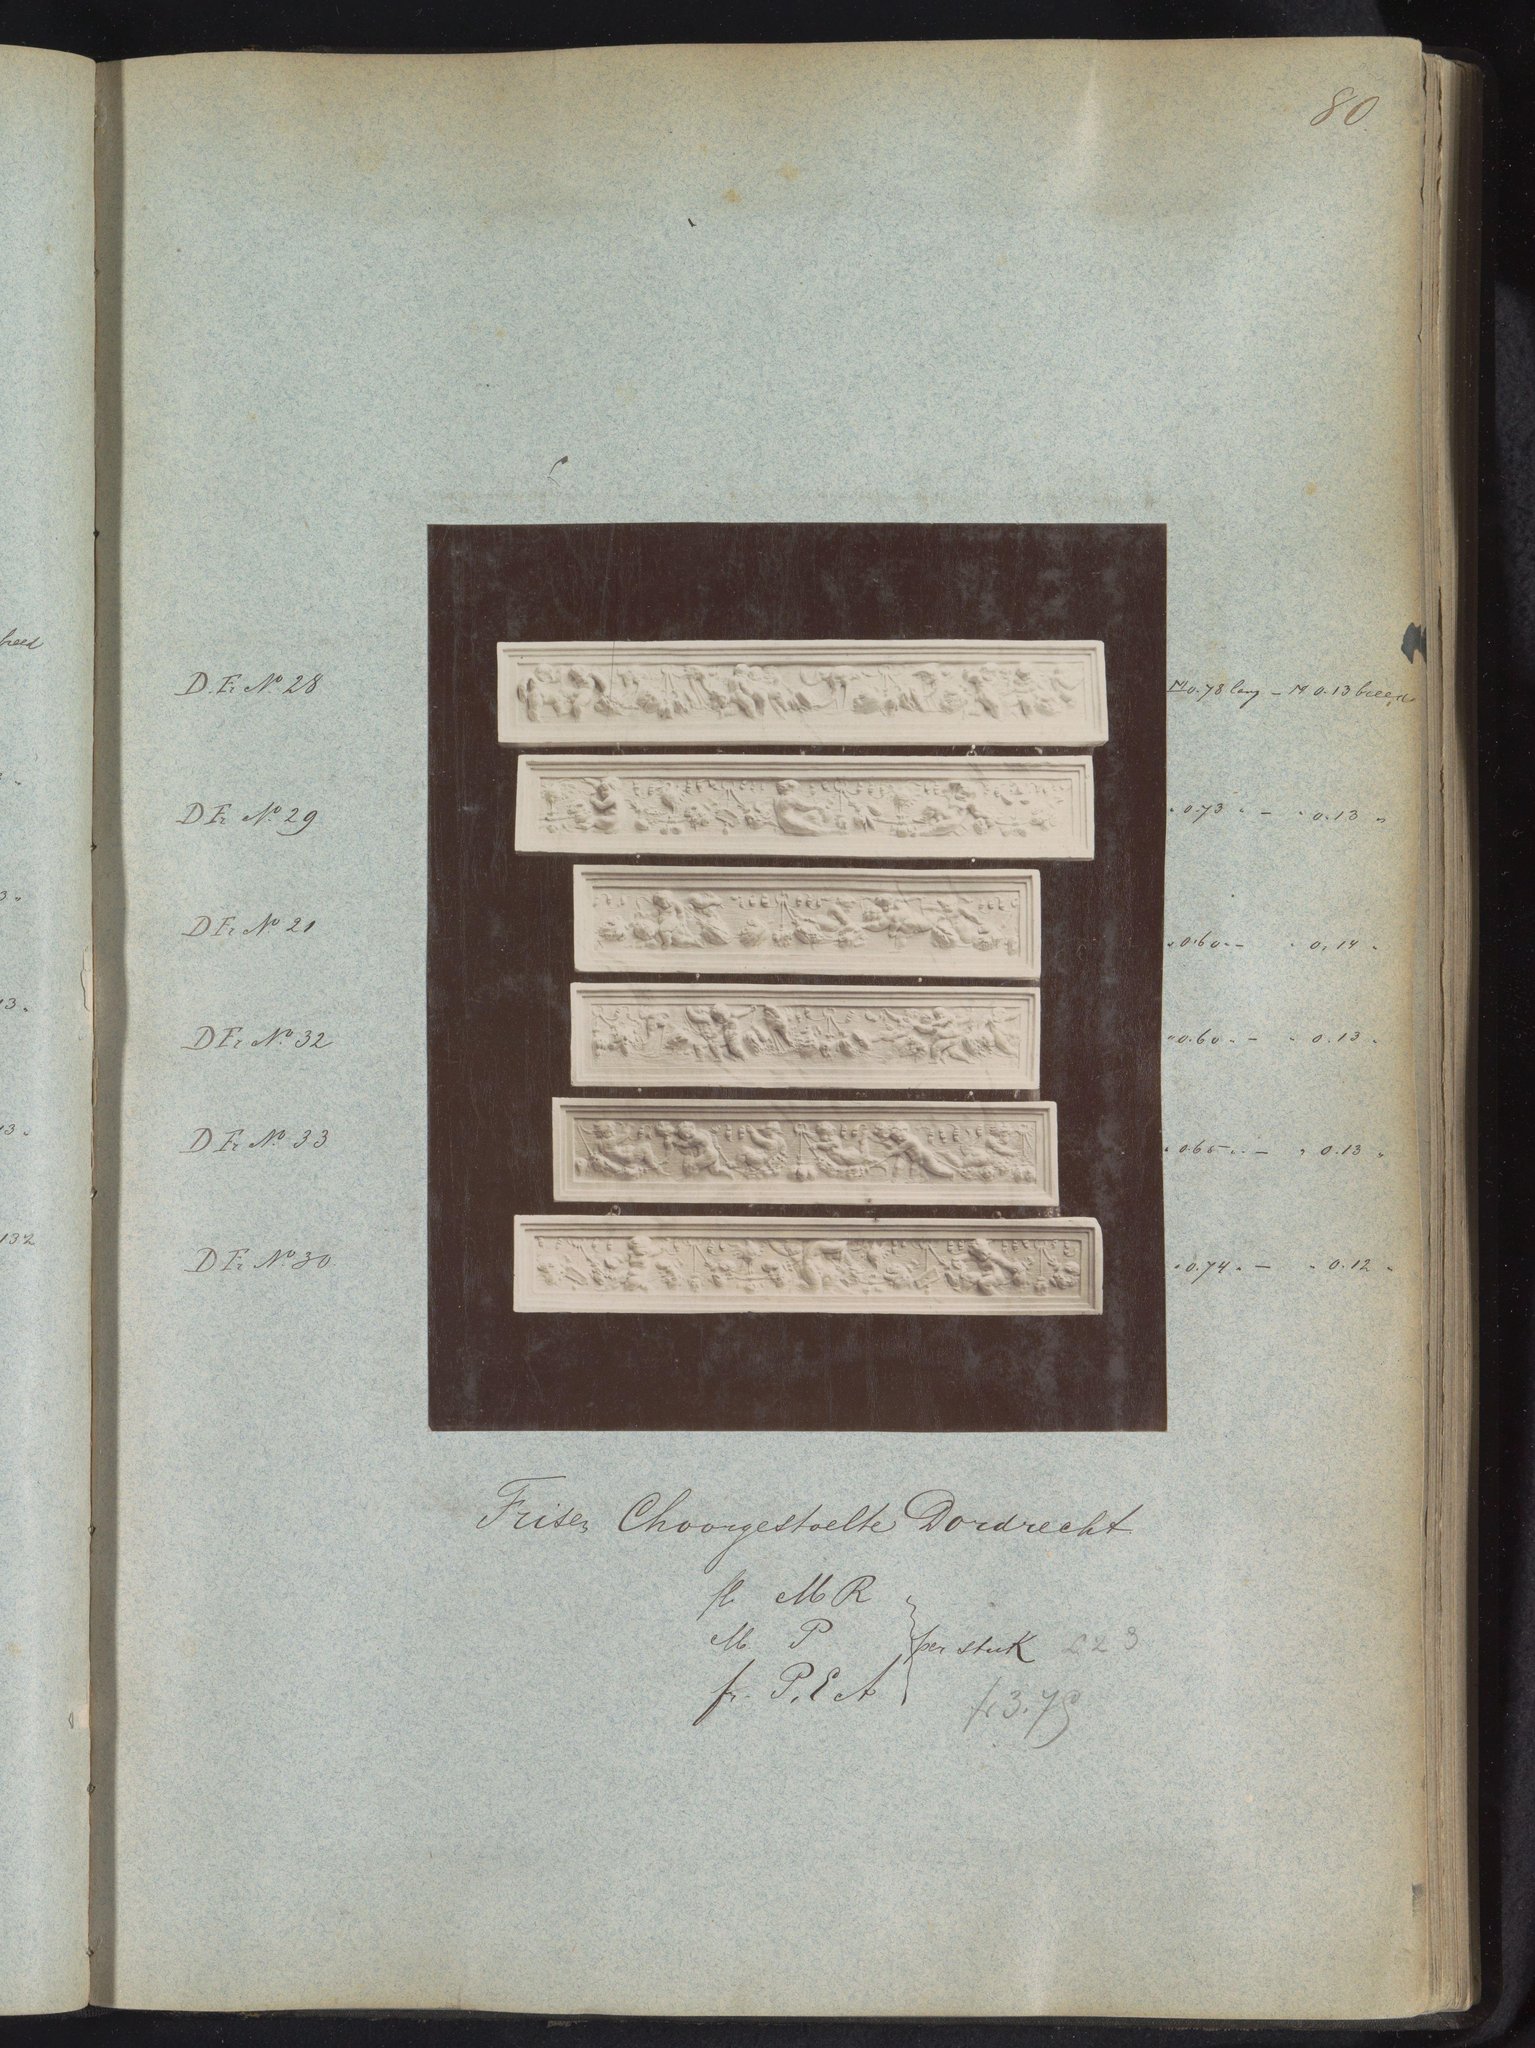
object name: album leaf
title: Zes gipsen afgietsels van friezen van een koorgestoelte, vermoedelijk van de Grote Kerk te Dordrecht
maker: Anonymous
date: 1875-1900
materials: paper, photographic support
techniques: albumen print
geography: dordrecht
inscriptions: annotation, annotation: ‘Frisen [?] koorgestoelte Dordrecht’